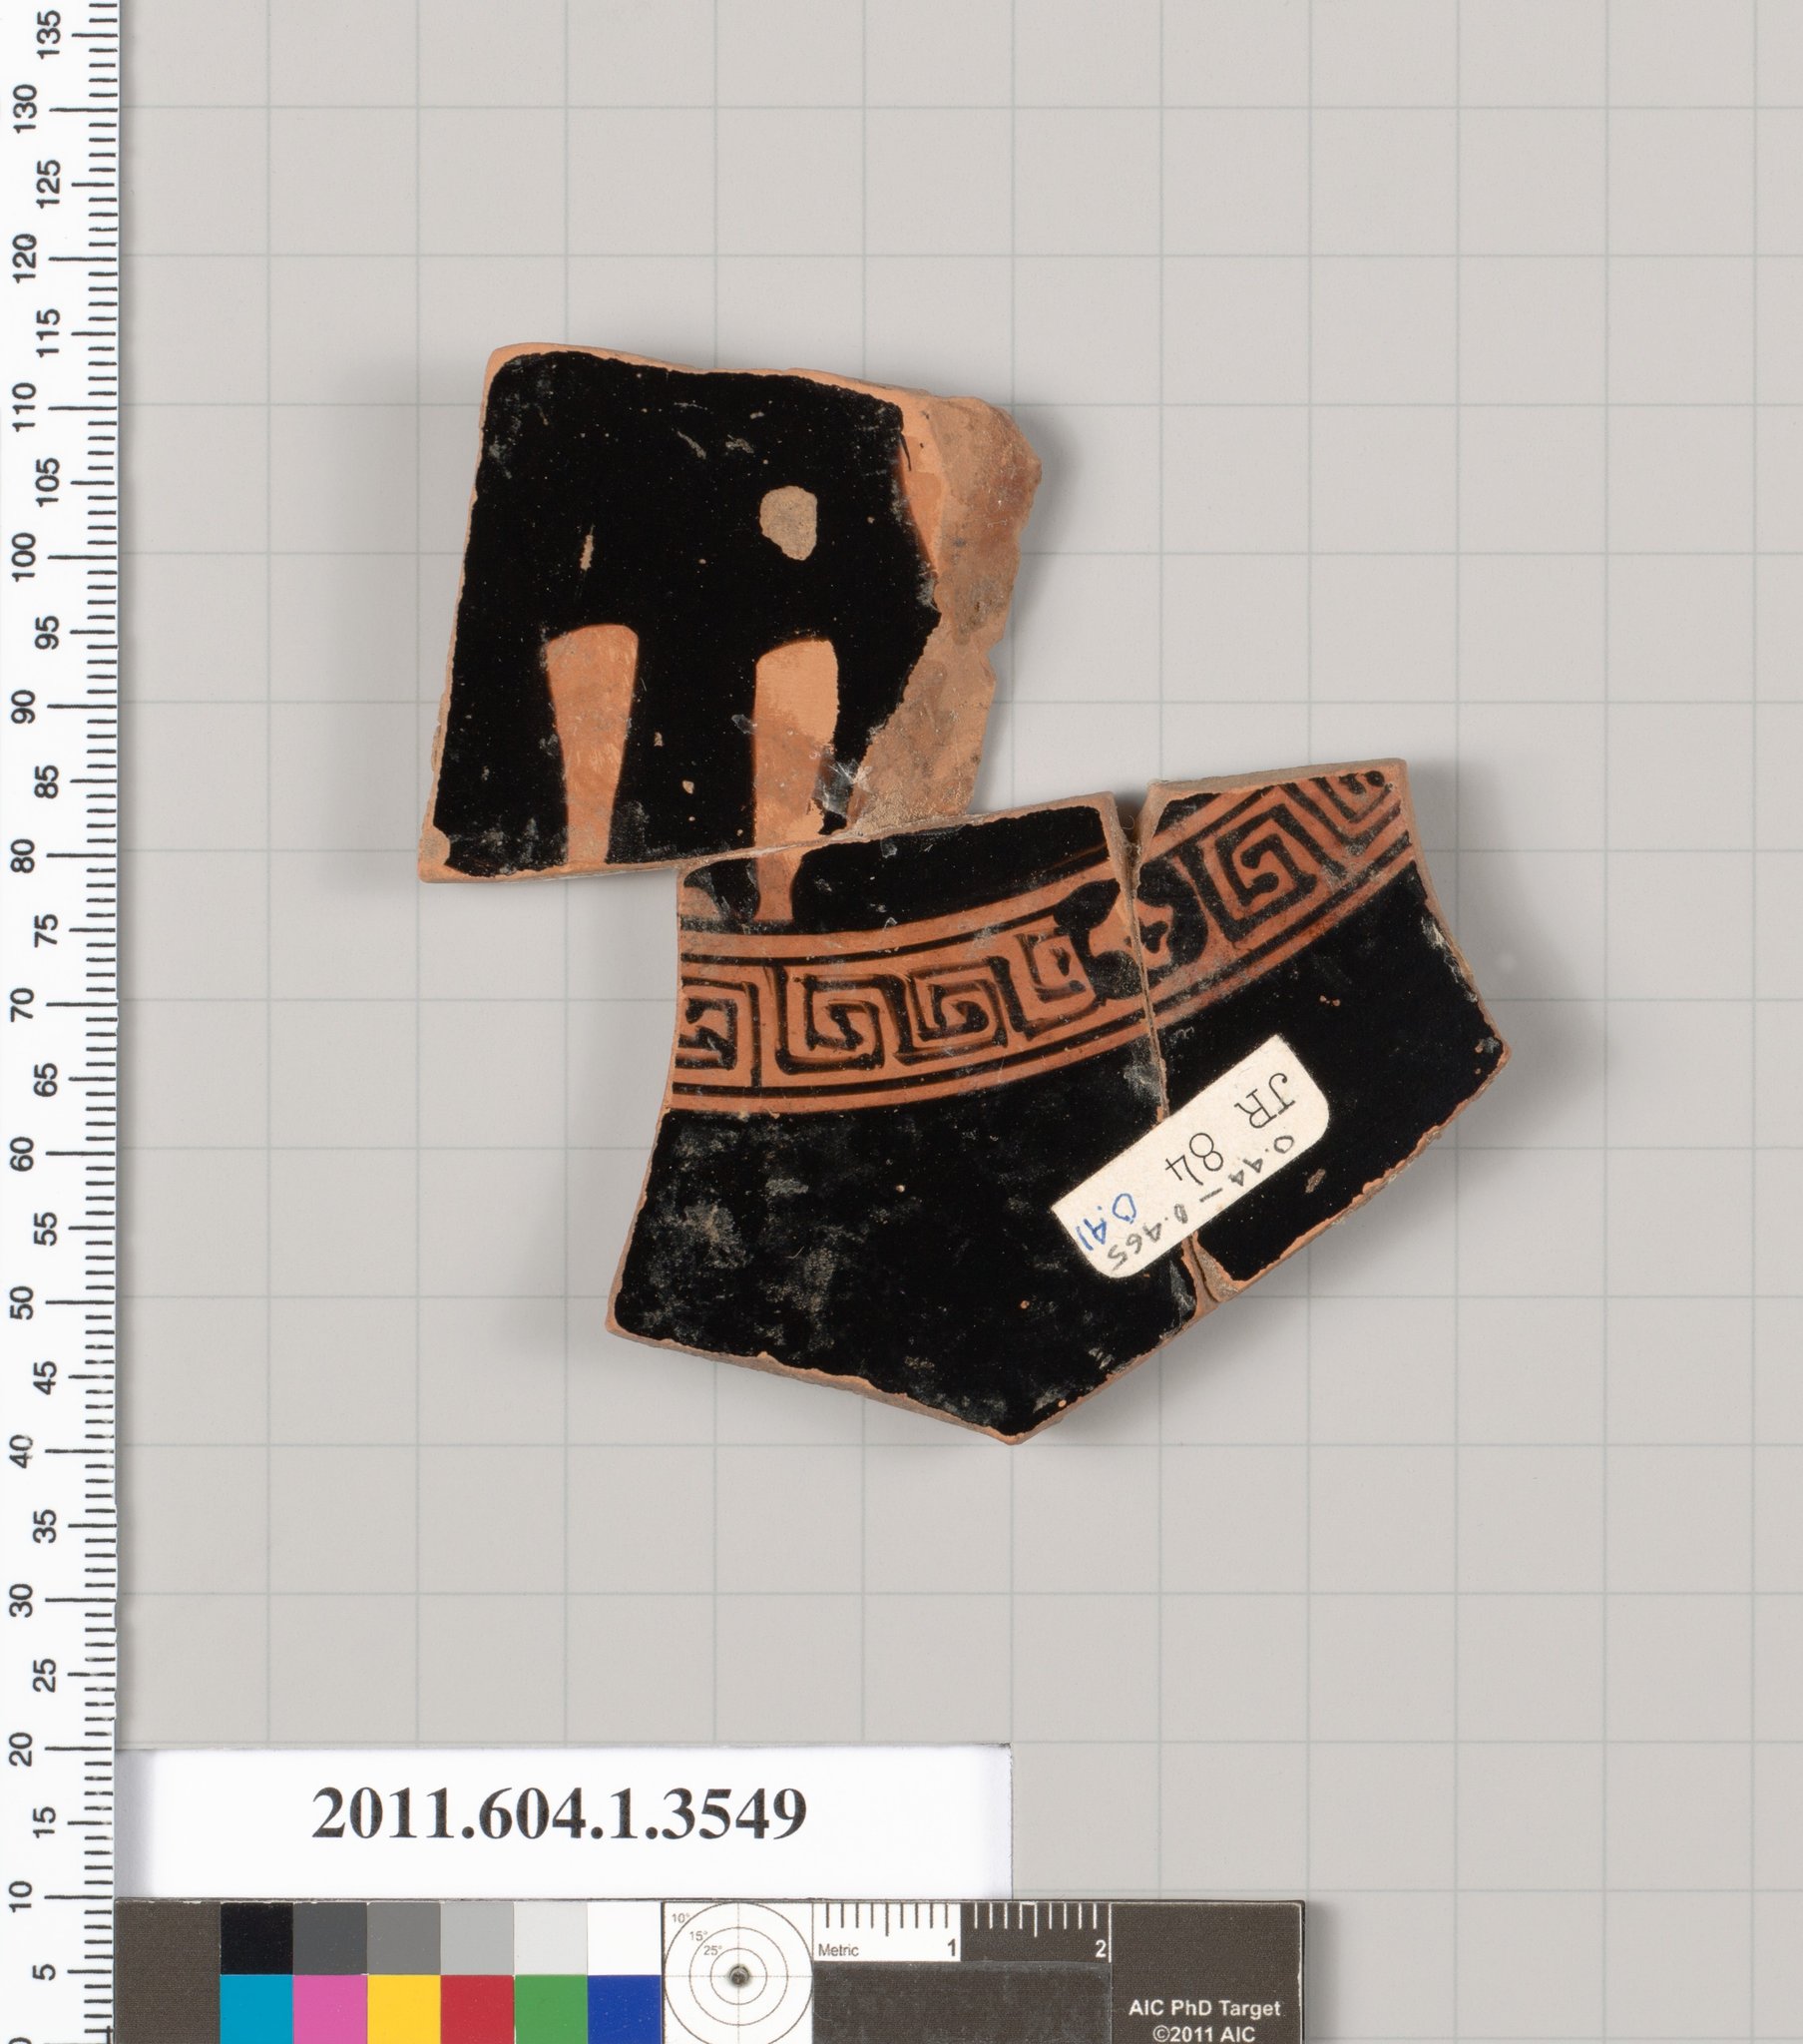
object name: kylix fragment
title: Terracotta fragment of a kylix (drinking cup)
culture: greek, attic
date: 475-451 BCE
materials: terracotta